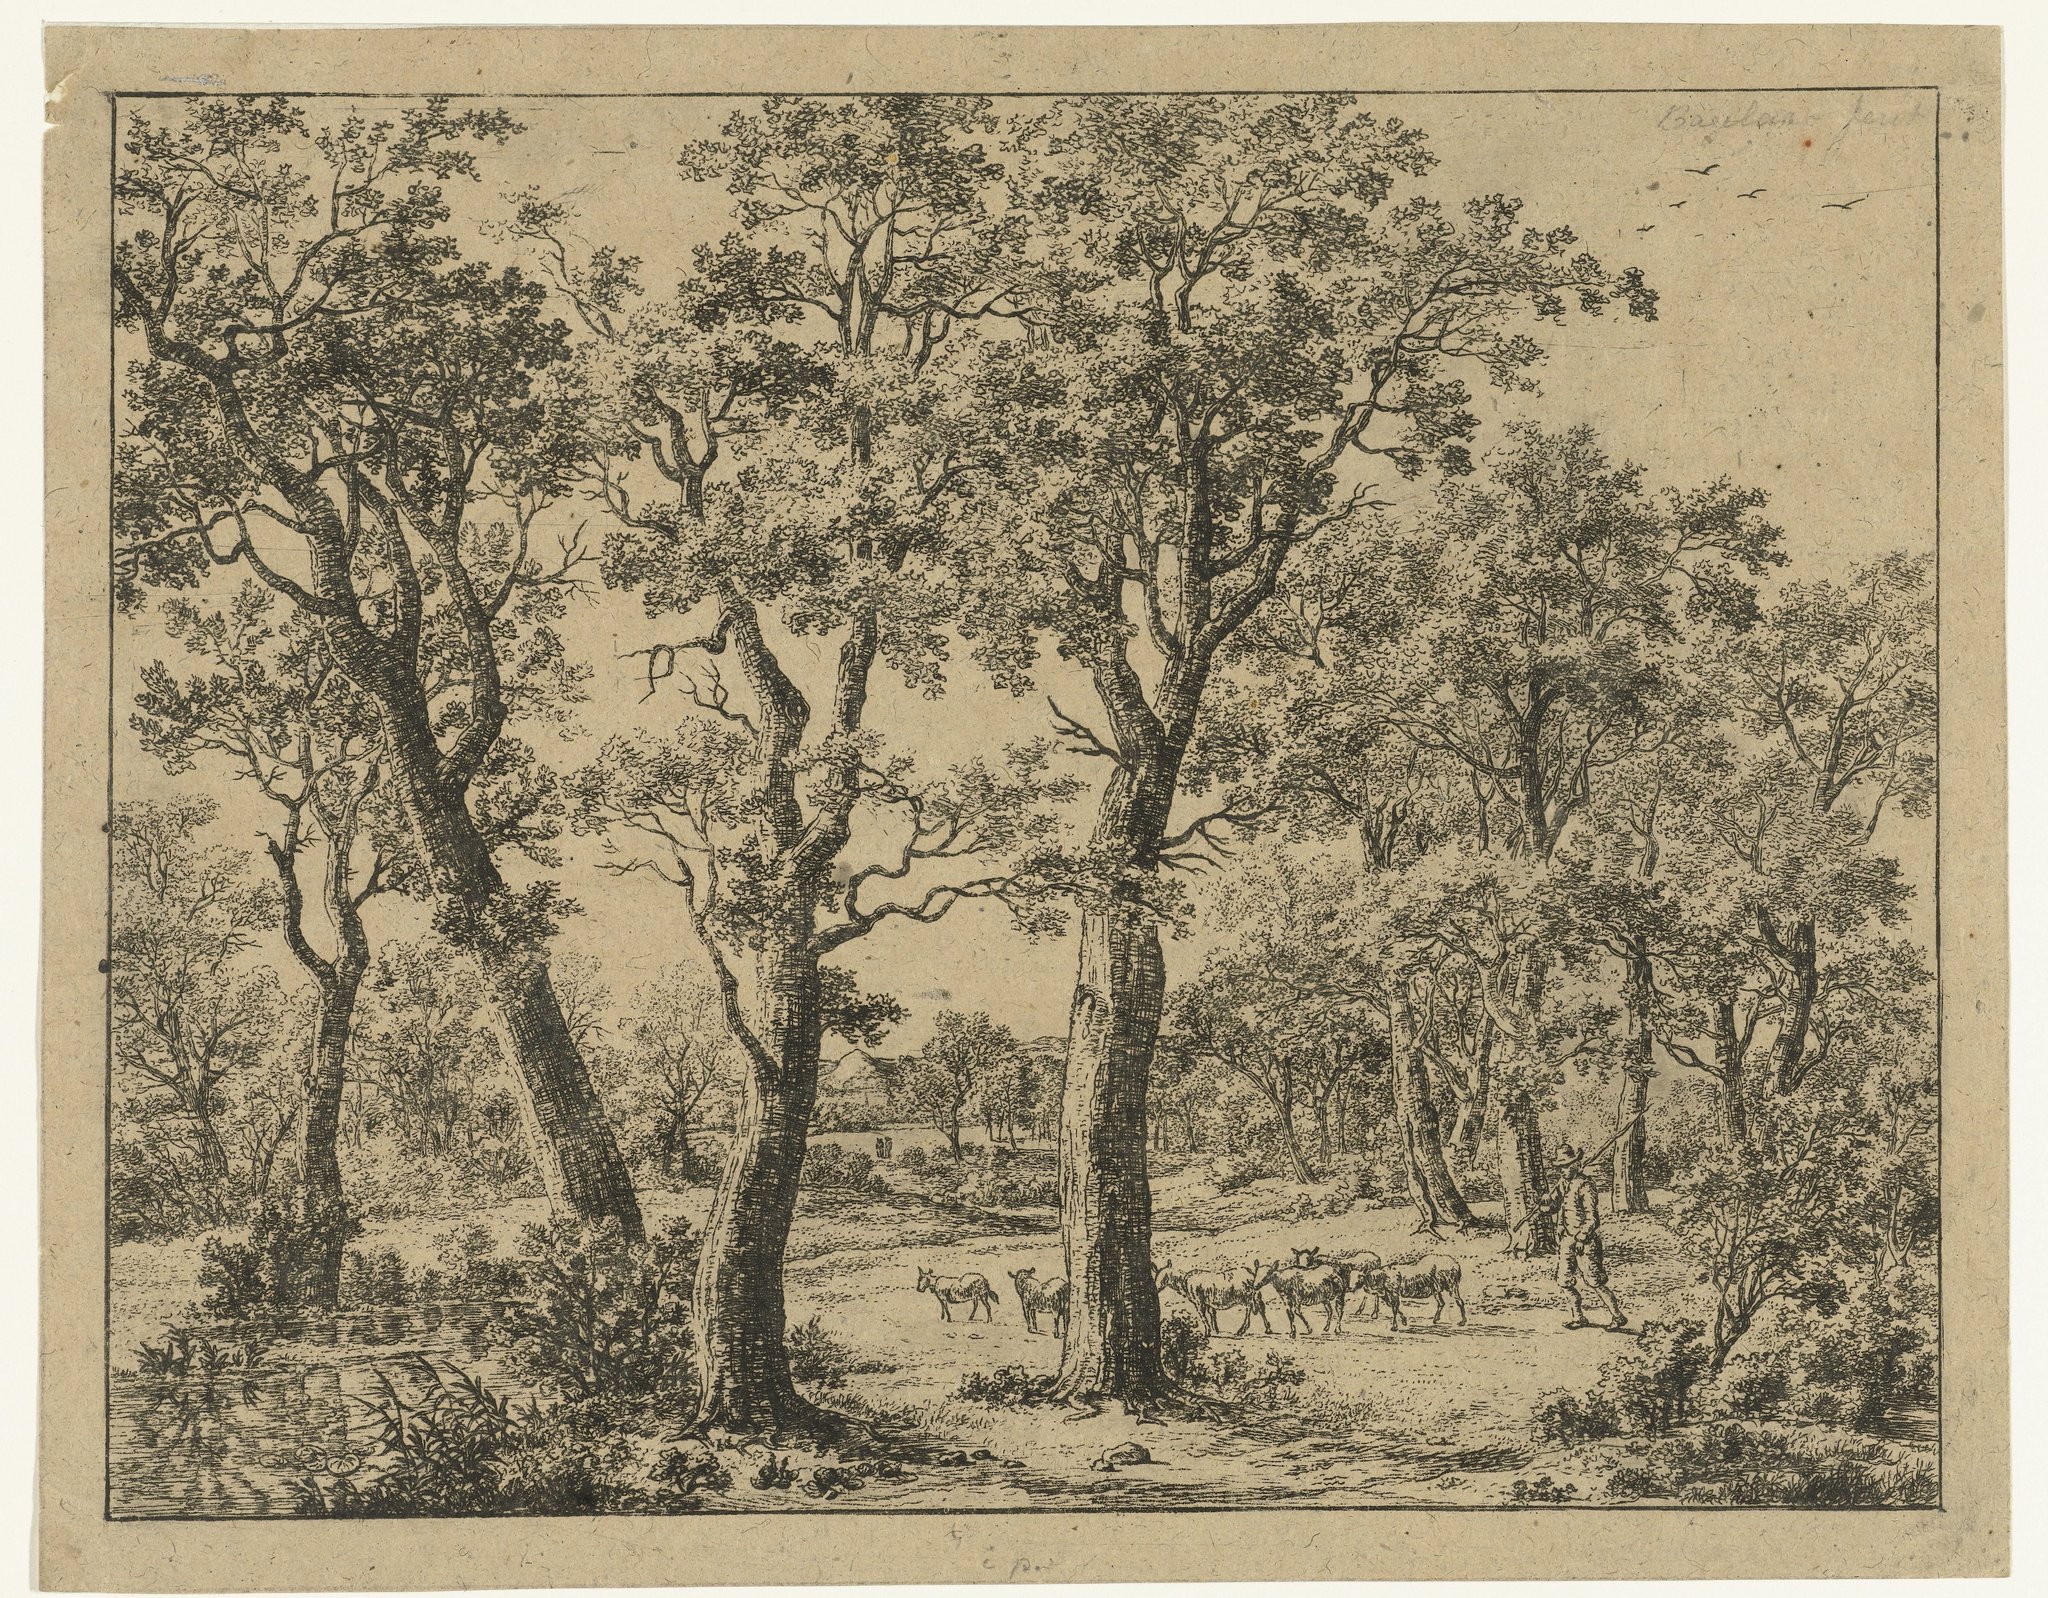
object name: print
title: Landschap met herder en schapen bij een water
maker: ernst willem jan bagelaar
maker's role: draughtsman, print maker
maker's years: 1775-1837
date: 1798-1837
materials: paper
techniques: etching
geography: netherlands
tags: herding, herdsman, herdswoman, shepherd, shepherdess, cowherd, etc.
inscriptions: collector's mark: Lugt 2228